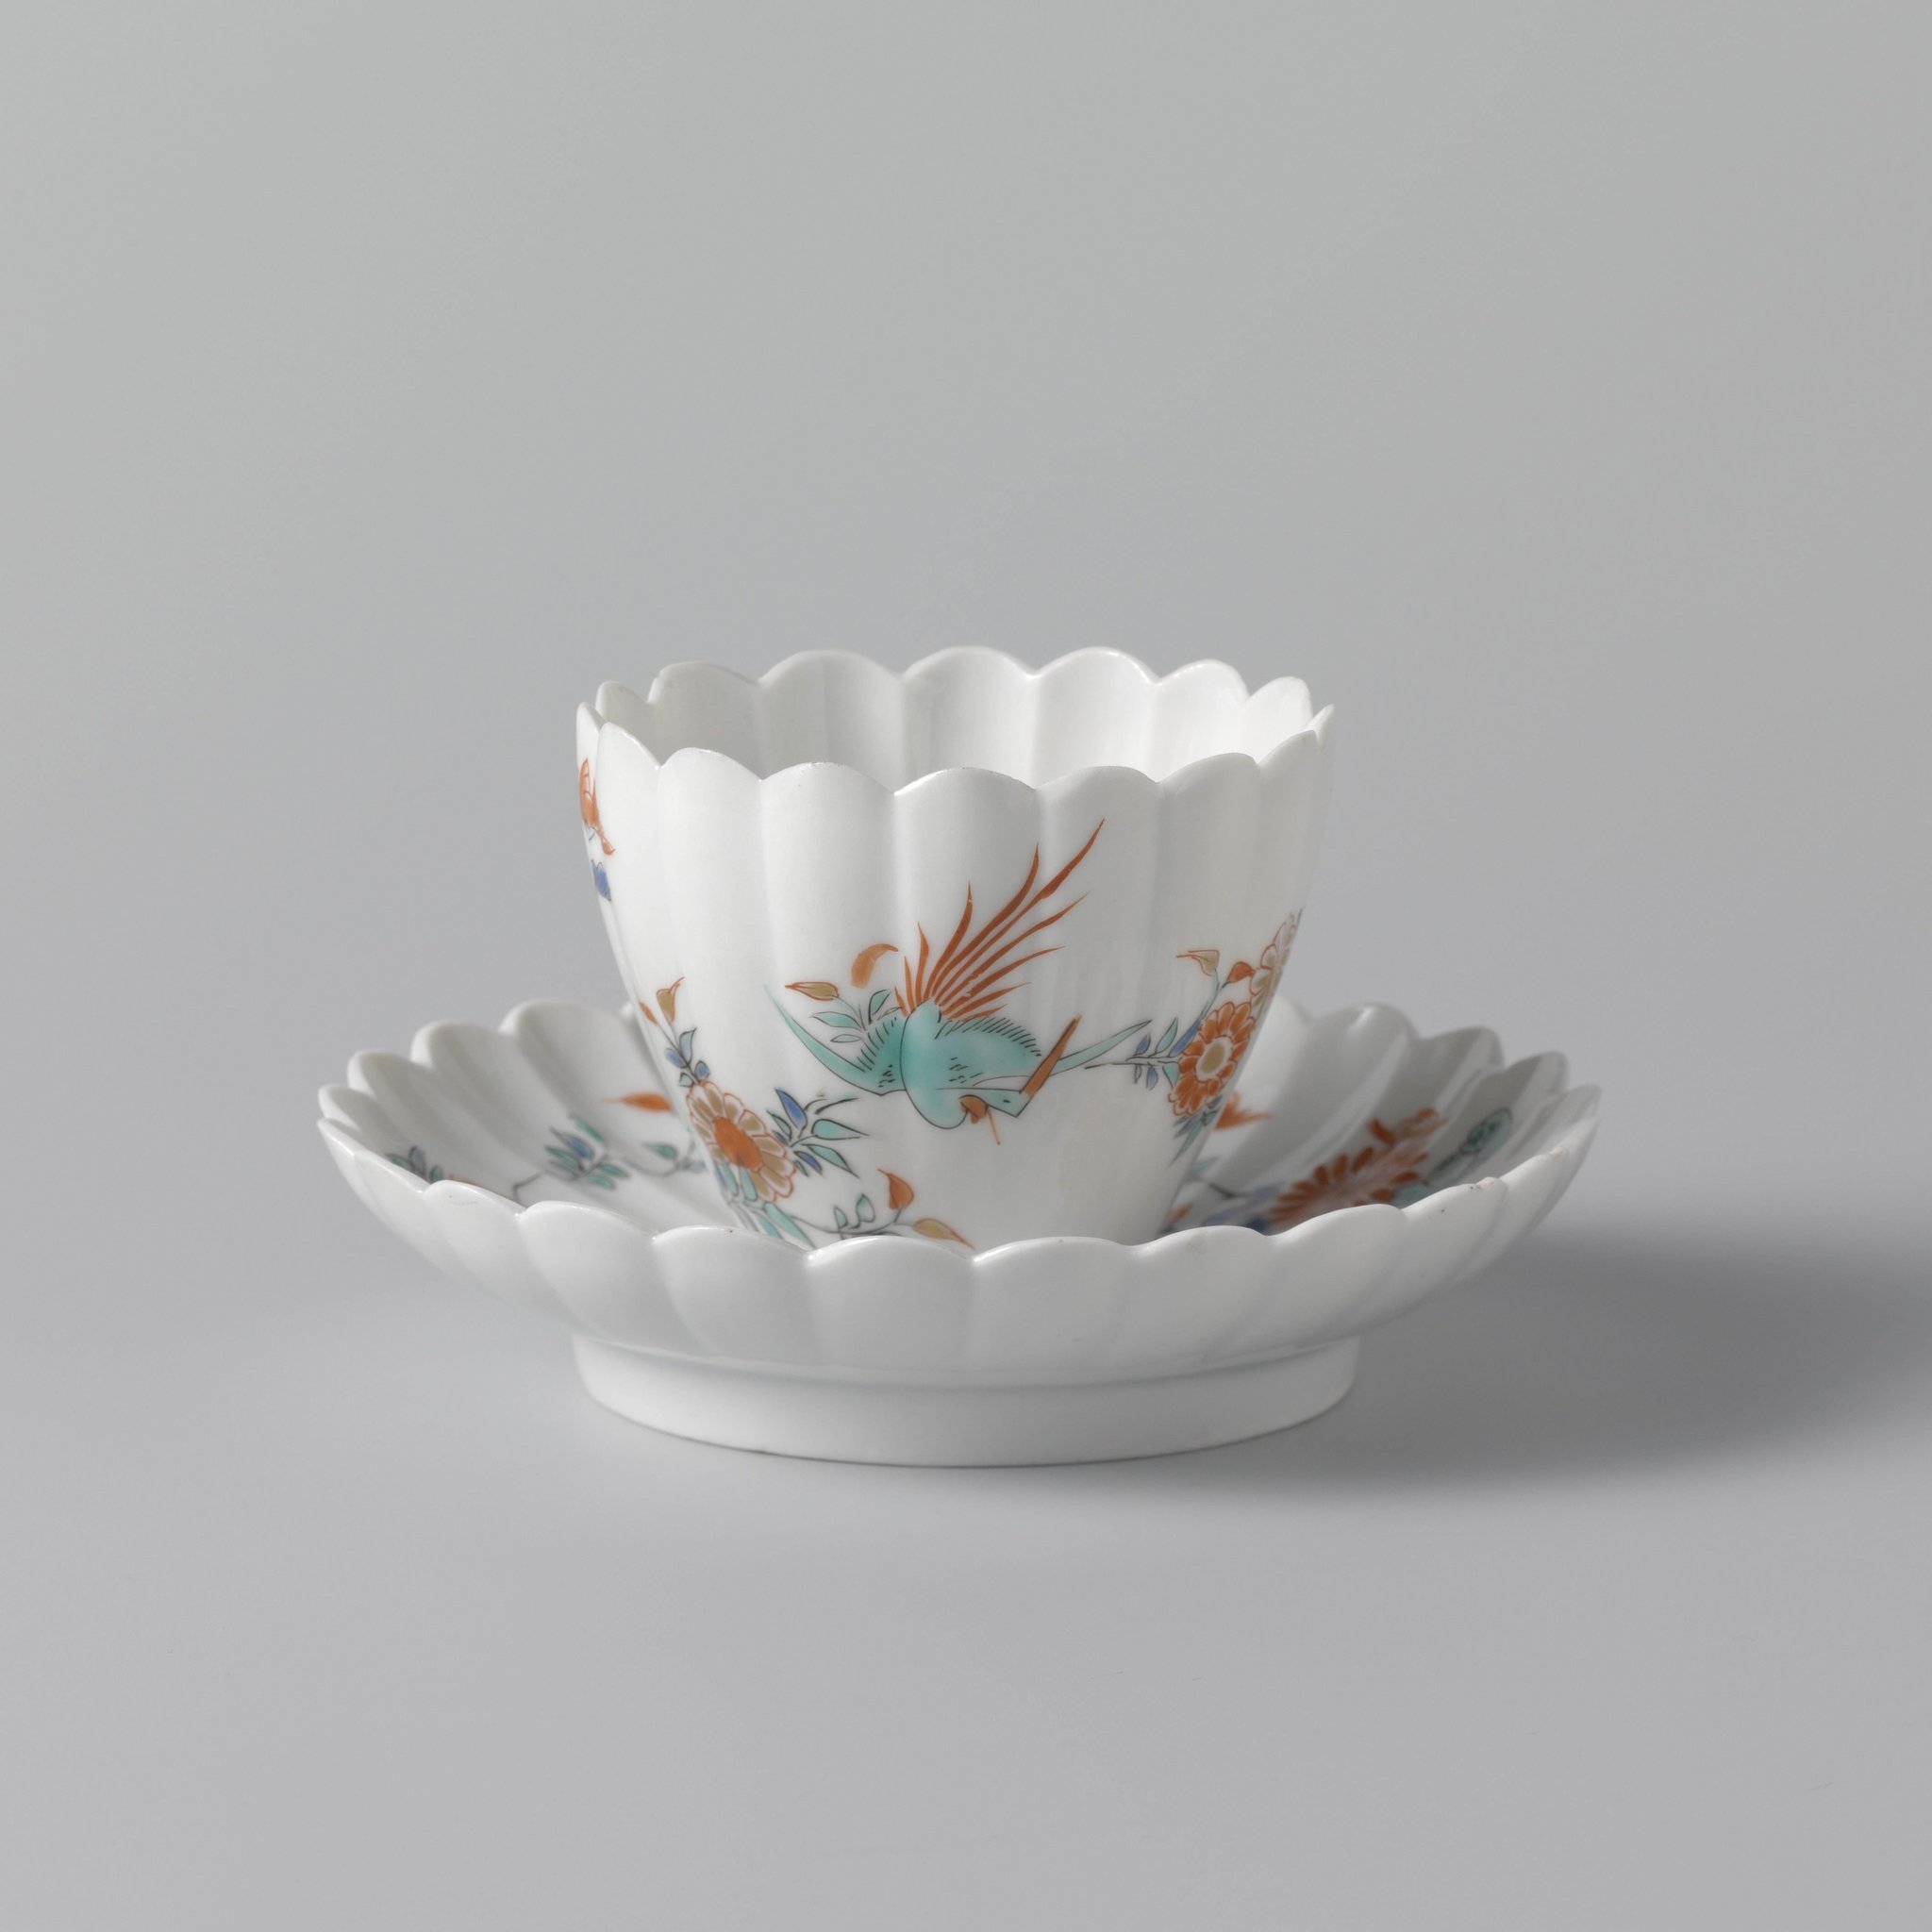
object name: kop en schotel, kop en schotel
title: Fluted cup and saucer with flower sprays and birds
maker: Anonymous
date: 1670-1700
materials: glaze, gold, paint, porcelain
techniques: firing, forming, gilding, turning, vitrification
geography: arita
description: Cup and saucer, c. 1750 - 1800.